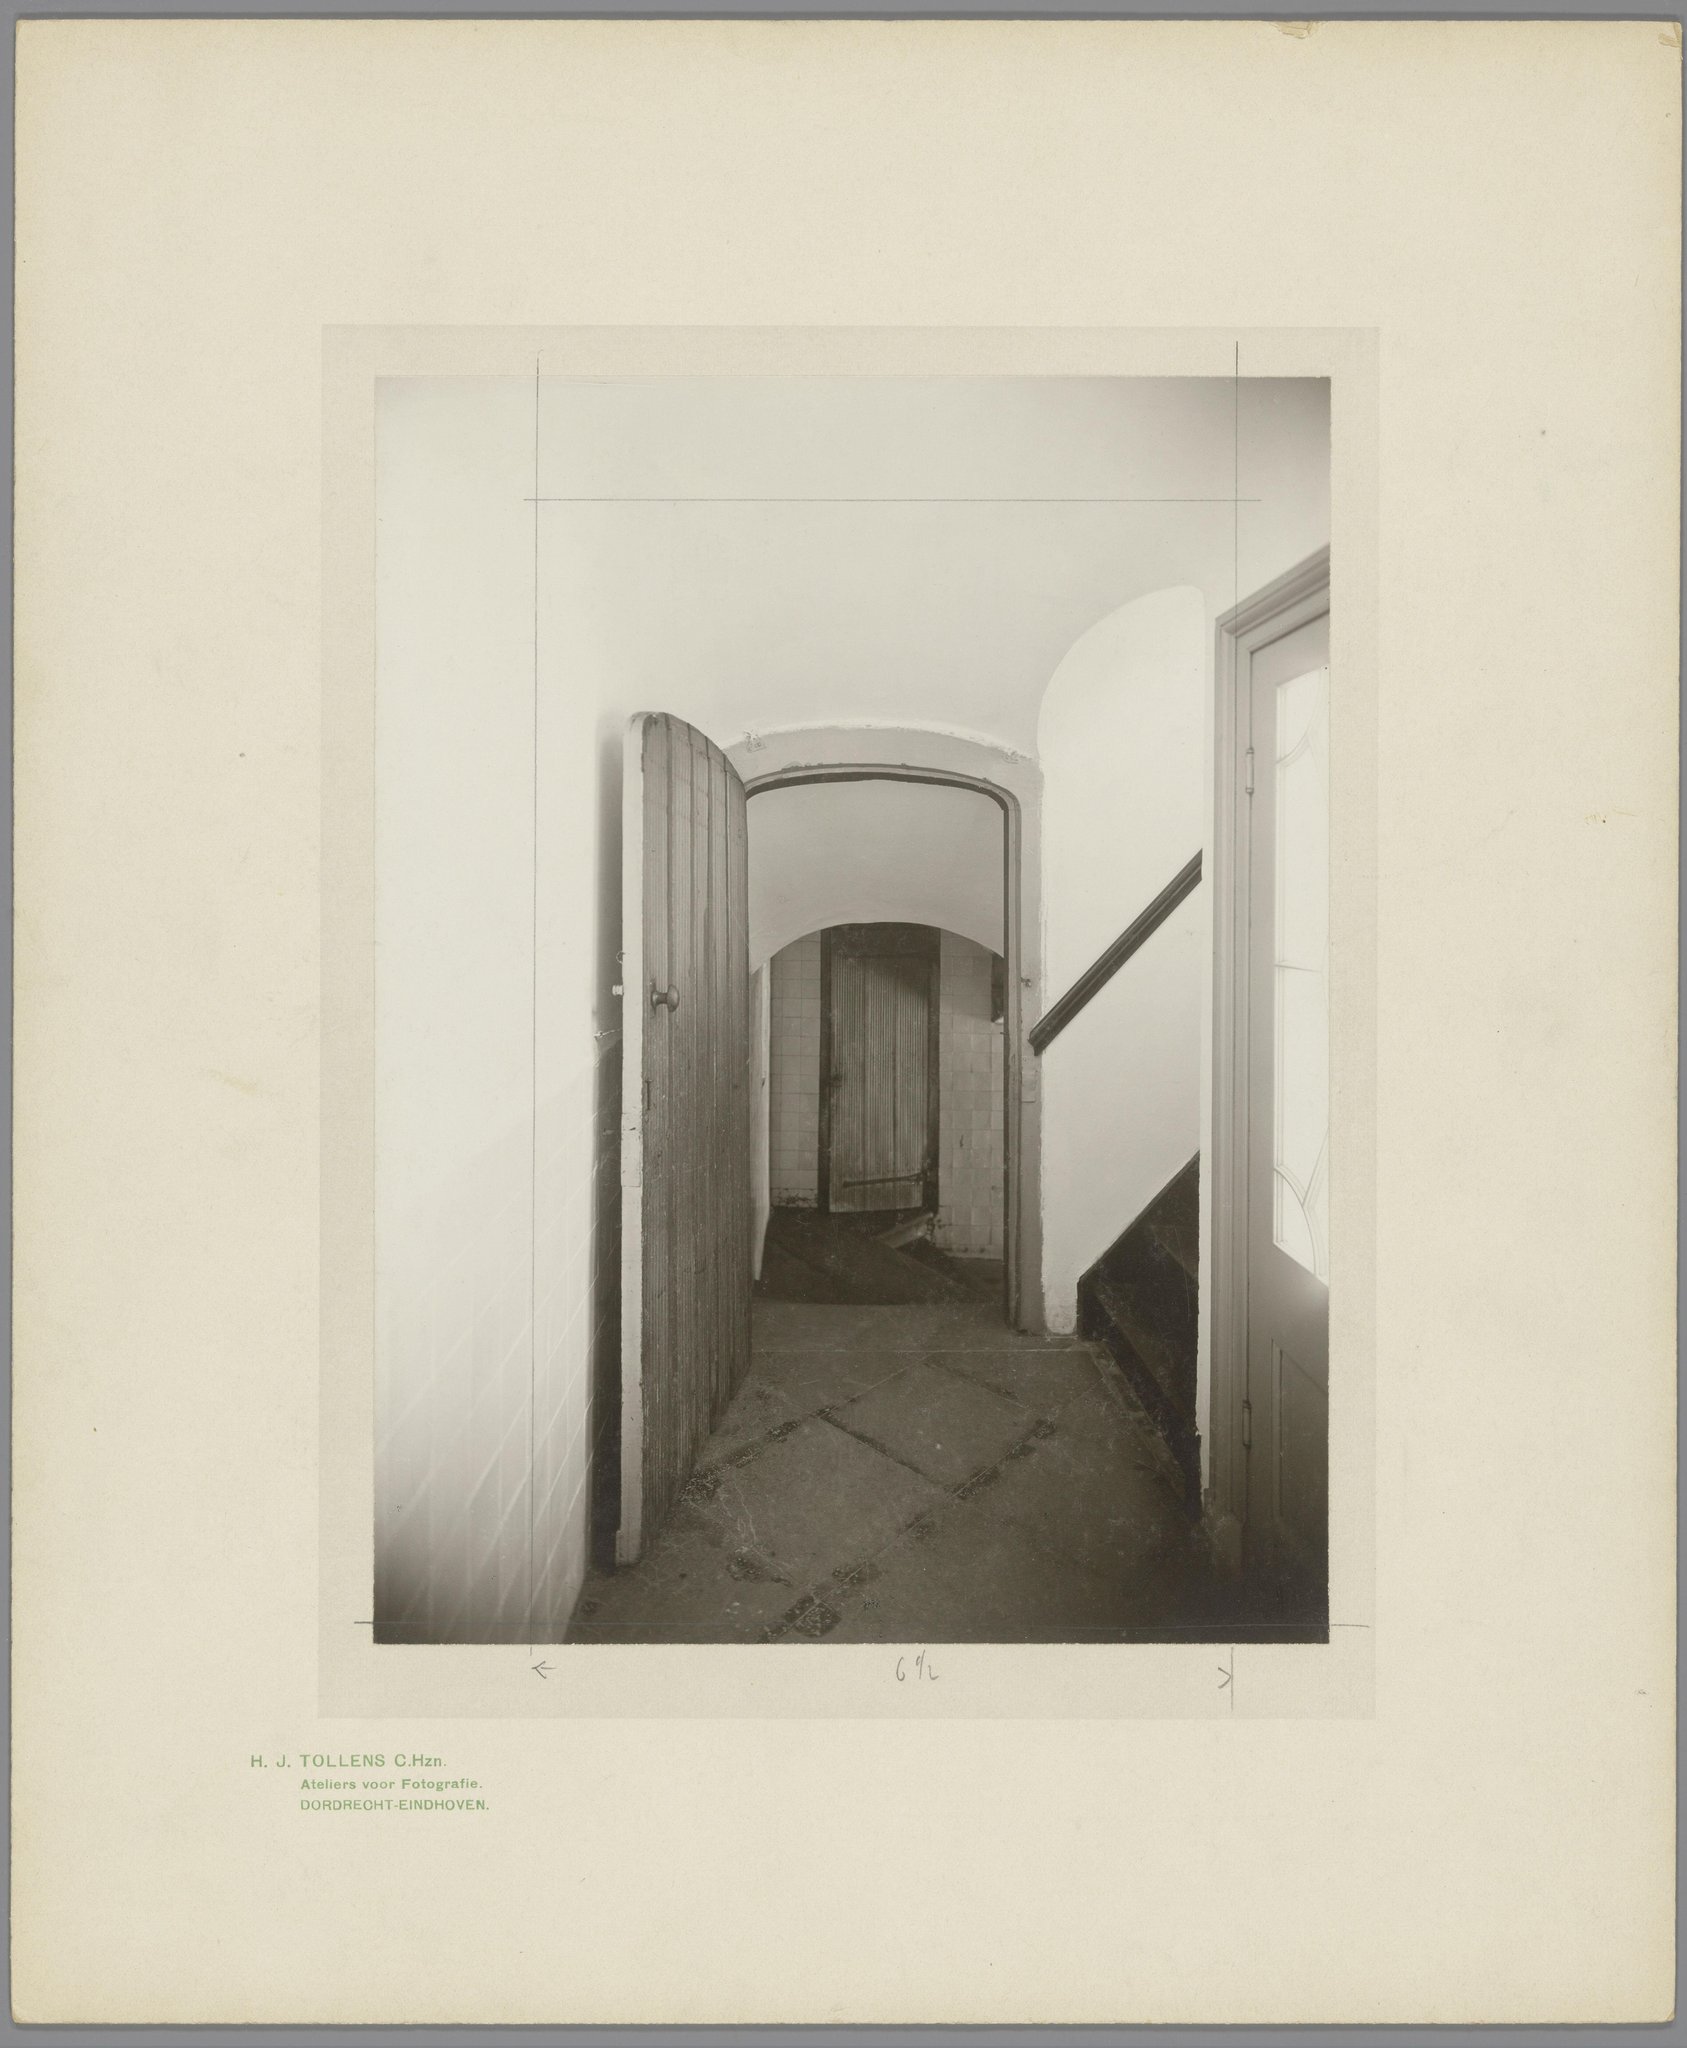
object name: photograph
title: Kelders in het Rijnlandshuis te Leiden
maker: henricus jacobus tollens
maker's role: painter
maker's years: 1864-1936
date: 1880-1910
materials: cardboard, photographic support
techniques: collodion silver print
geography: leiden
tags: basement, cellar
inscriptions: number: ‘116’, annotation: ‘toegang tot de gewelfde kelders waarin/ Rijnlands gevangenis aanwezig was’, annotation: ‘No.2/ Leiden/ Gemeenlandshuis’, inscription: ‘H.J. Tollens C. Hzn./ Ateliers voor Fotografie/ Dordrecht-Eindhoven’